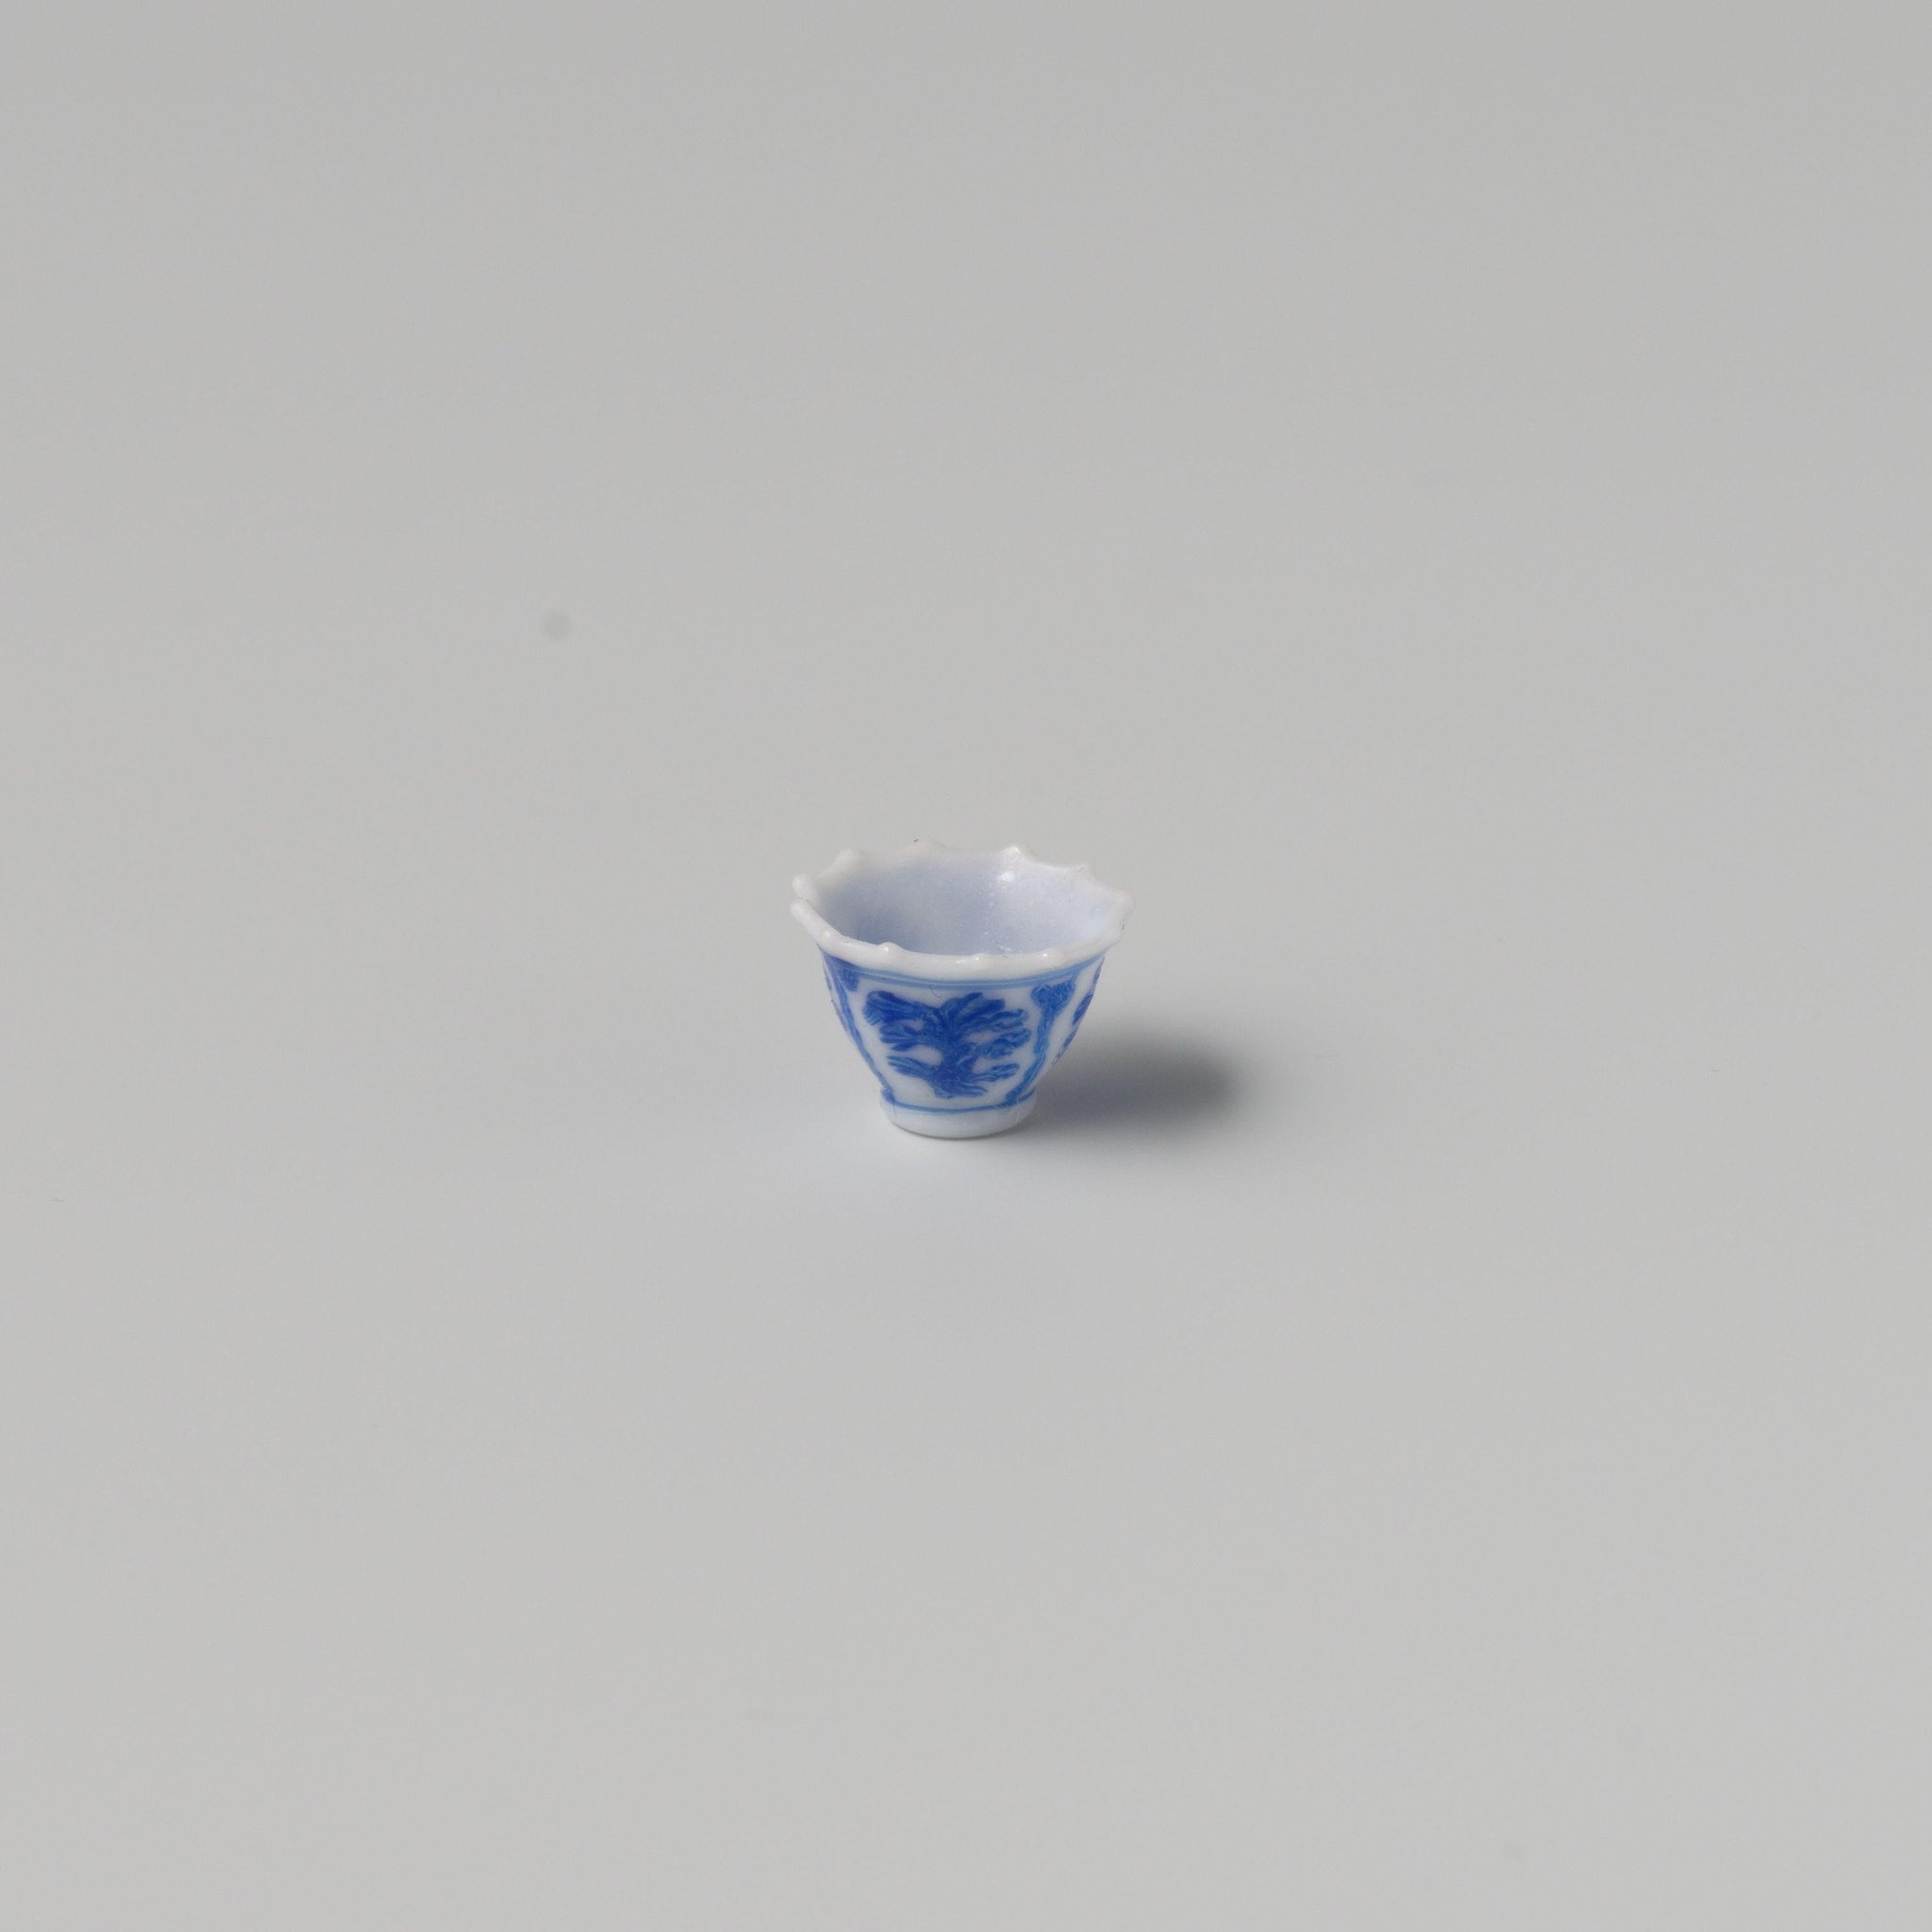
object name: cup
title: Theekopje van melkglas met blauwe emailverf beschildering, imitatie Chinees porselein met 'bloem' decoratie in drie vakken; model met puntrand, nauwelijks een standring.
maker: Anonymous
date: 1675-1710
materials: glass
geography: amsterdam